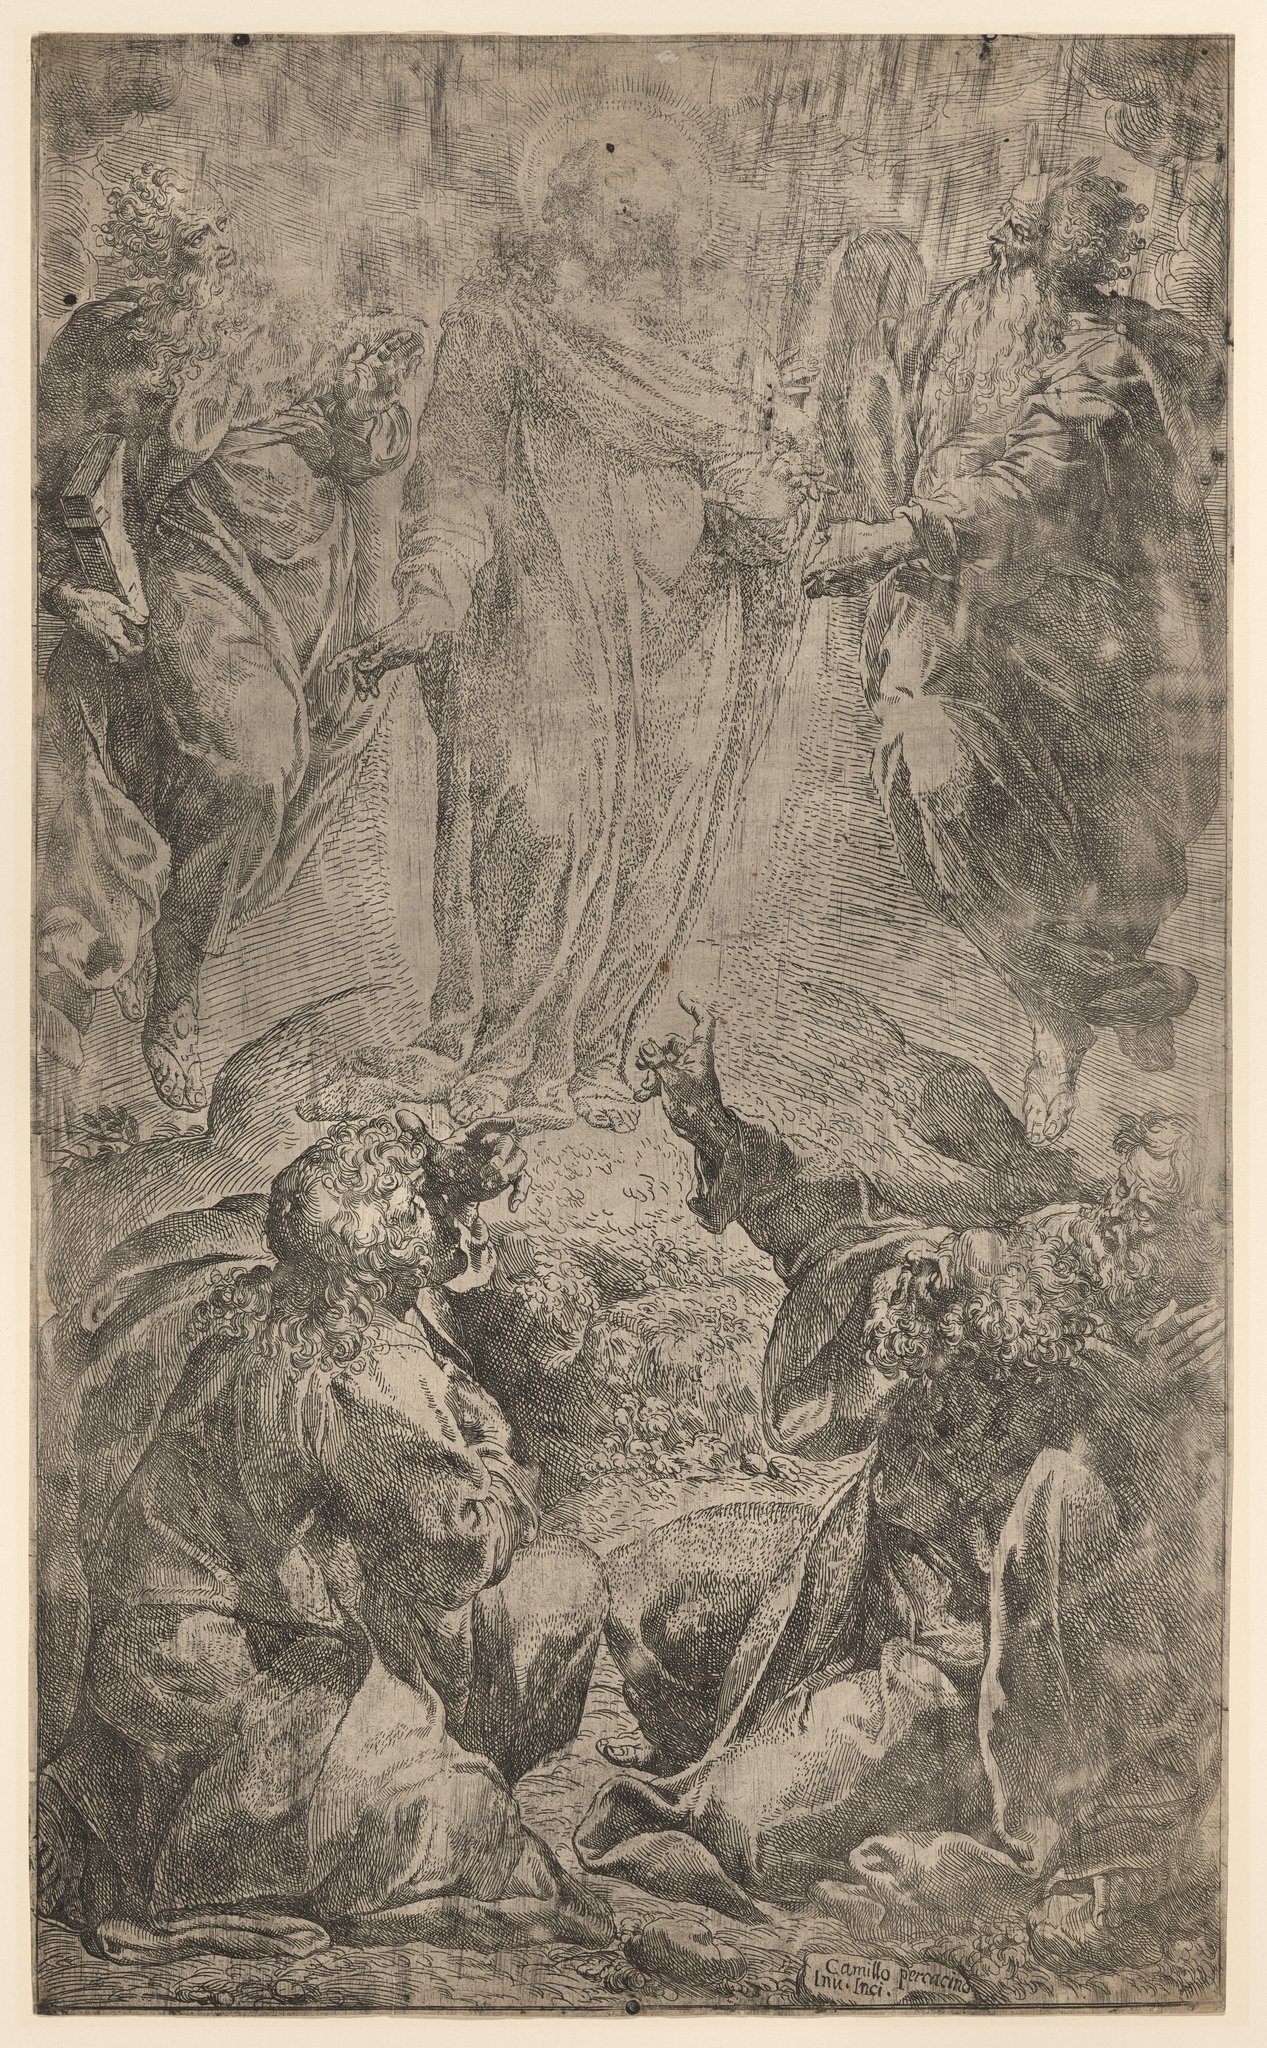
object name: print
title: The Transfiguration of Christ on Mount Tabor, with Moses and Elijah, three disciples below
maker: camillo procaccini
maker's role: artist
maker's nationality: italian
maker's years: 1555-1629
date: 1587-1590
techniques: etching